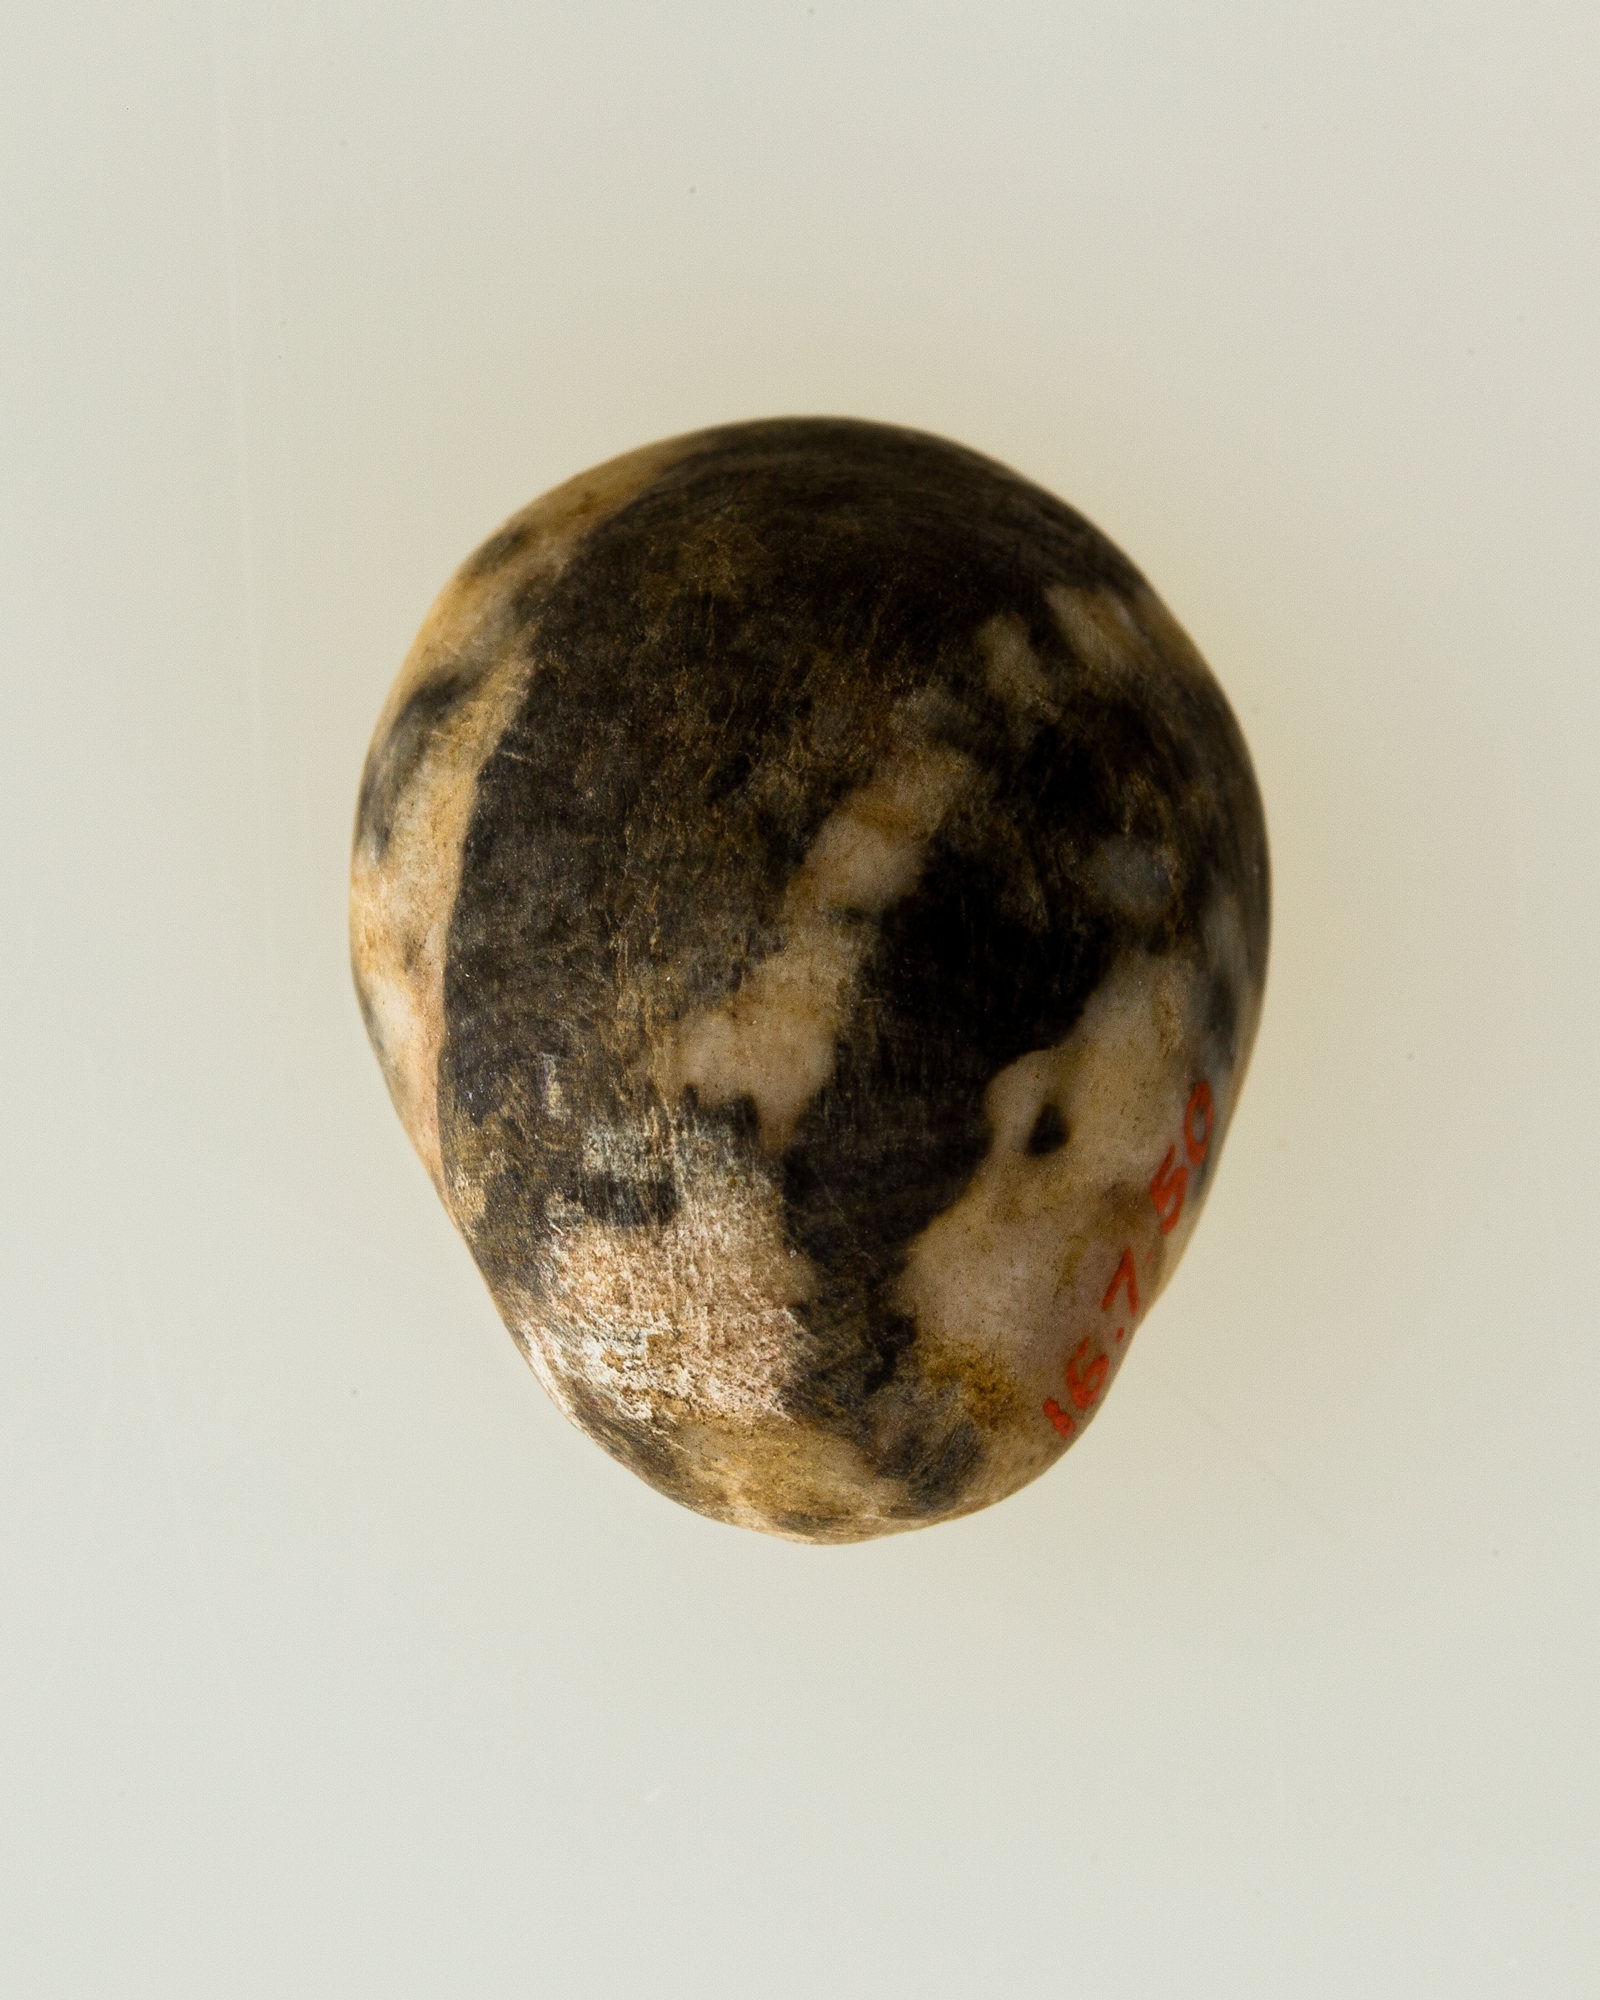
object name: pendant, shell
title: Shell pendant or bead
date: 3850-2960 BCE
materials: shell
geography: egypt